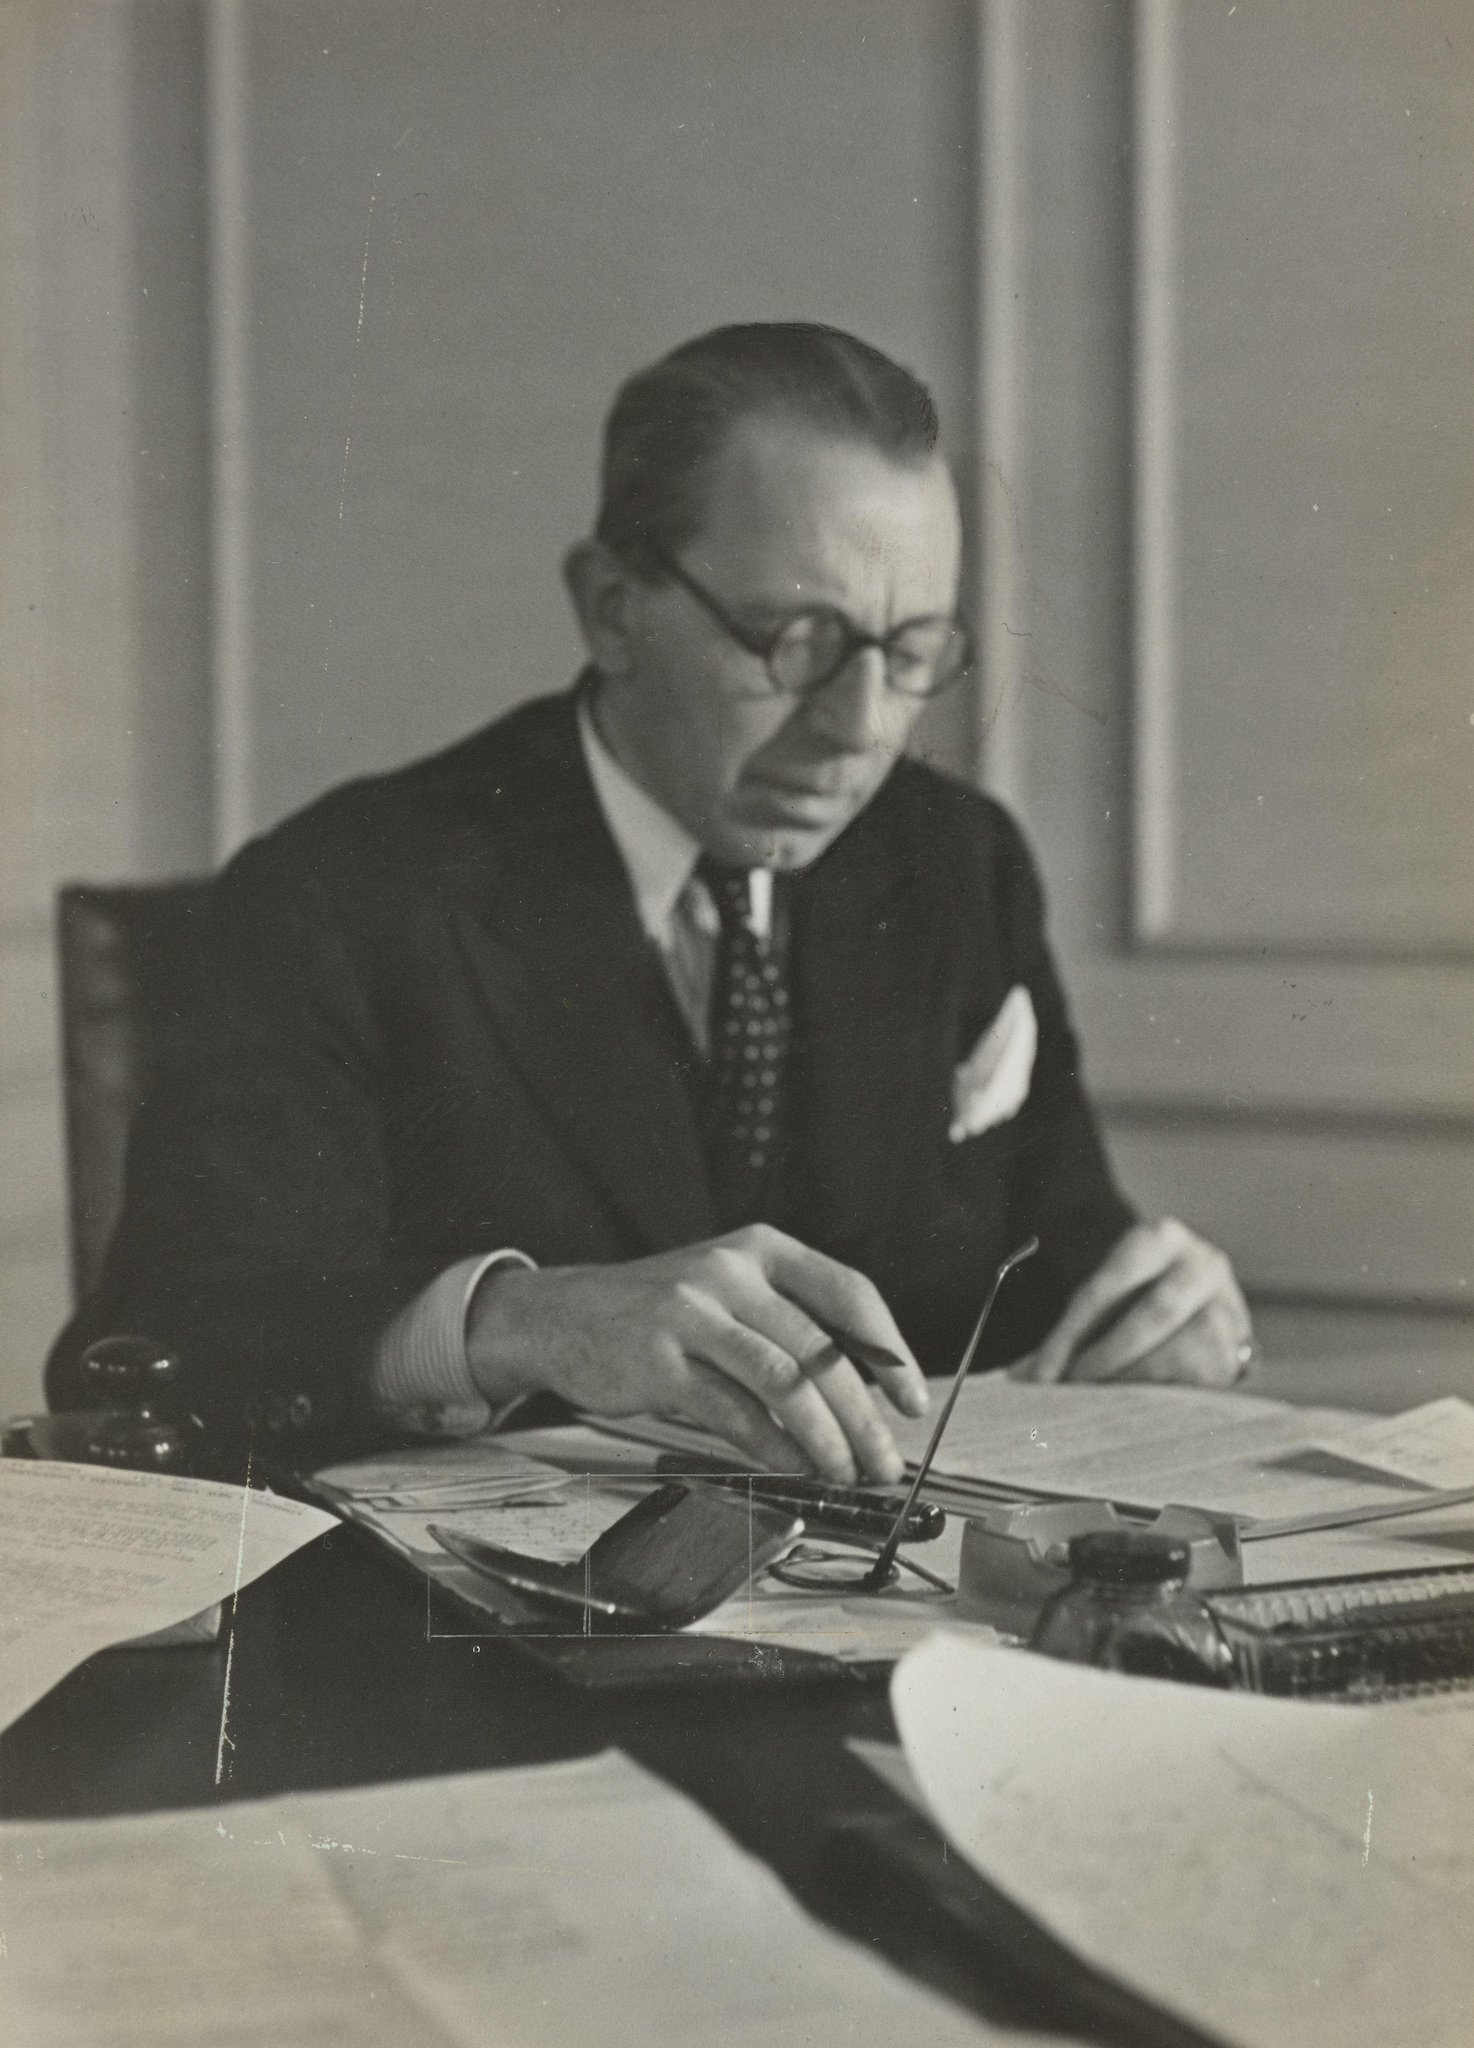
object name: photograph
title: Minister Van Angeren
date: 1940-1945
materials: photographic support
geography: london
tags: london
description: Minister Johannes Regnerus Maria van Angeren (1894-1959) was tijdens de Tweede Wereldoorlog minister van justitie. Hij vluchtte in mei 1940 als secretaris-generaal van het ministerie van justitie naar Engeland en volgde Gerbrandy later in Londen op als minister van Justitie. In 1944 kwam hij in conflict met de koningin over de naoorlogse politieorganisatie. Na zijn aftreden als minister in 1944 werd hij weer secretaris-generaal. Foto afkomstig uit het archief van Cor Visser